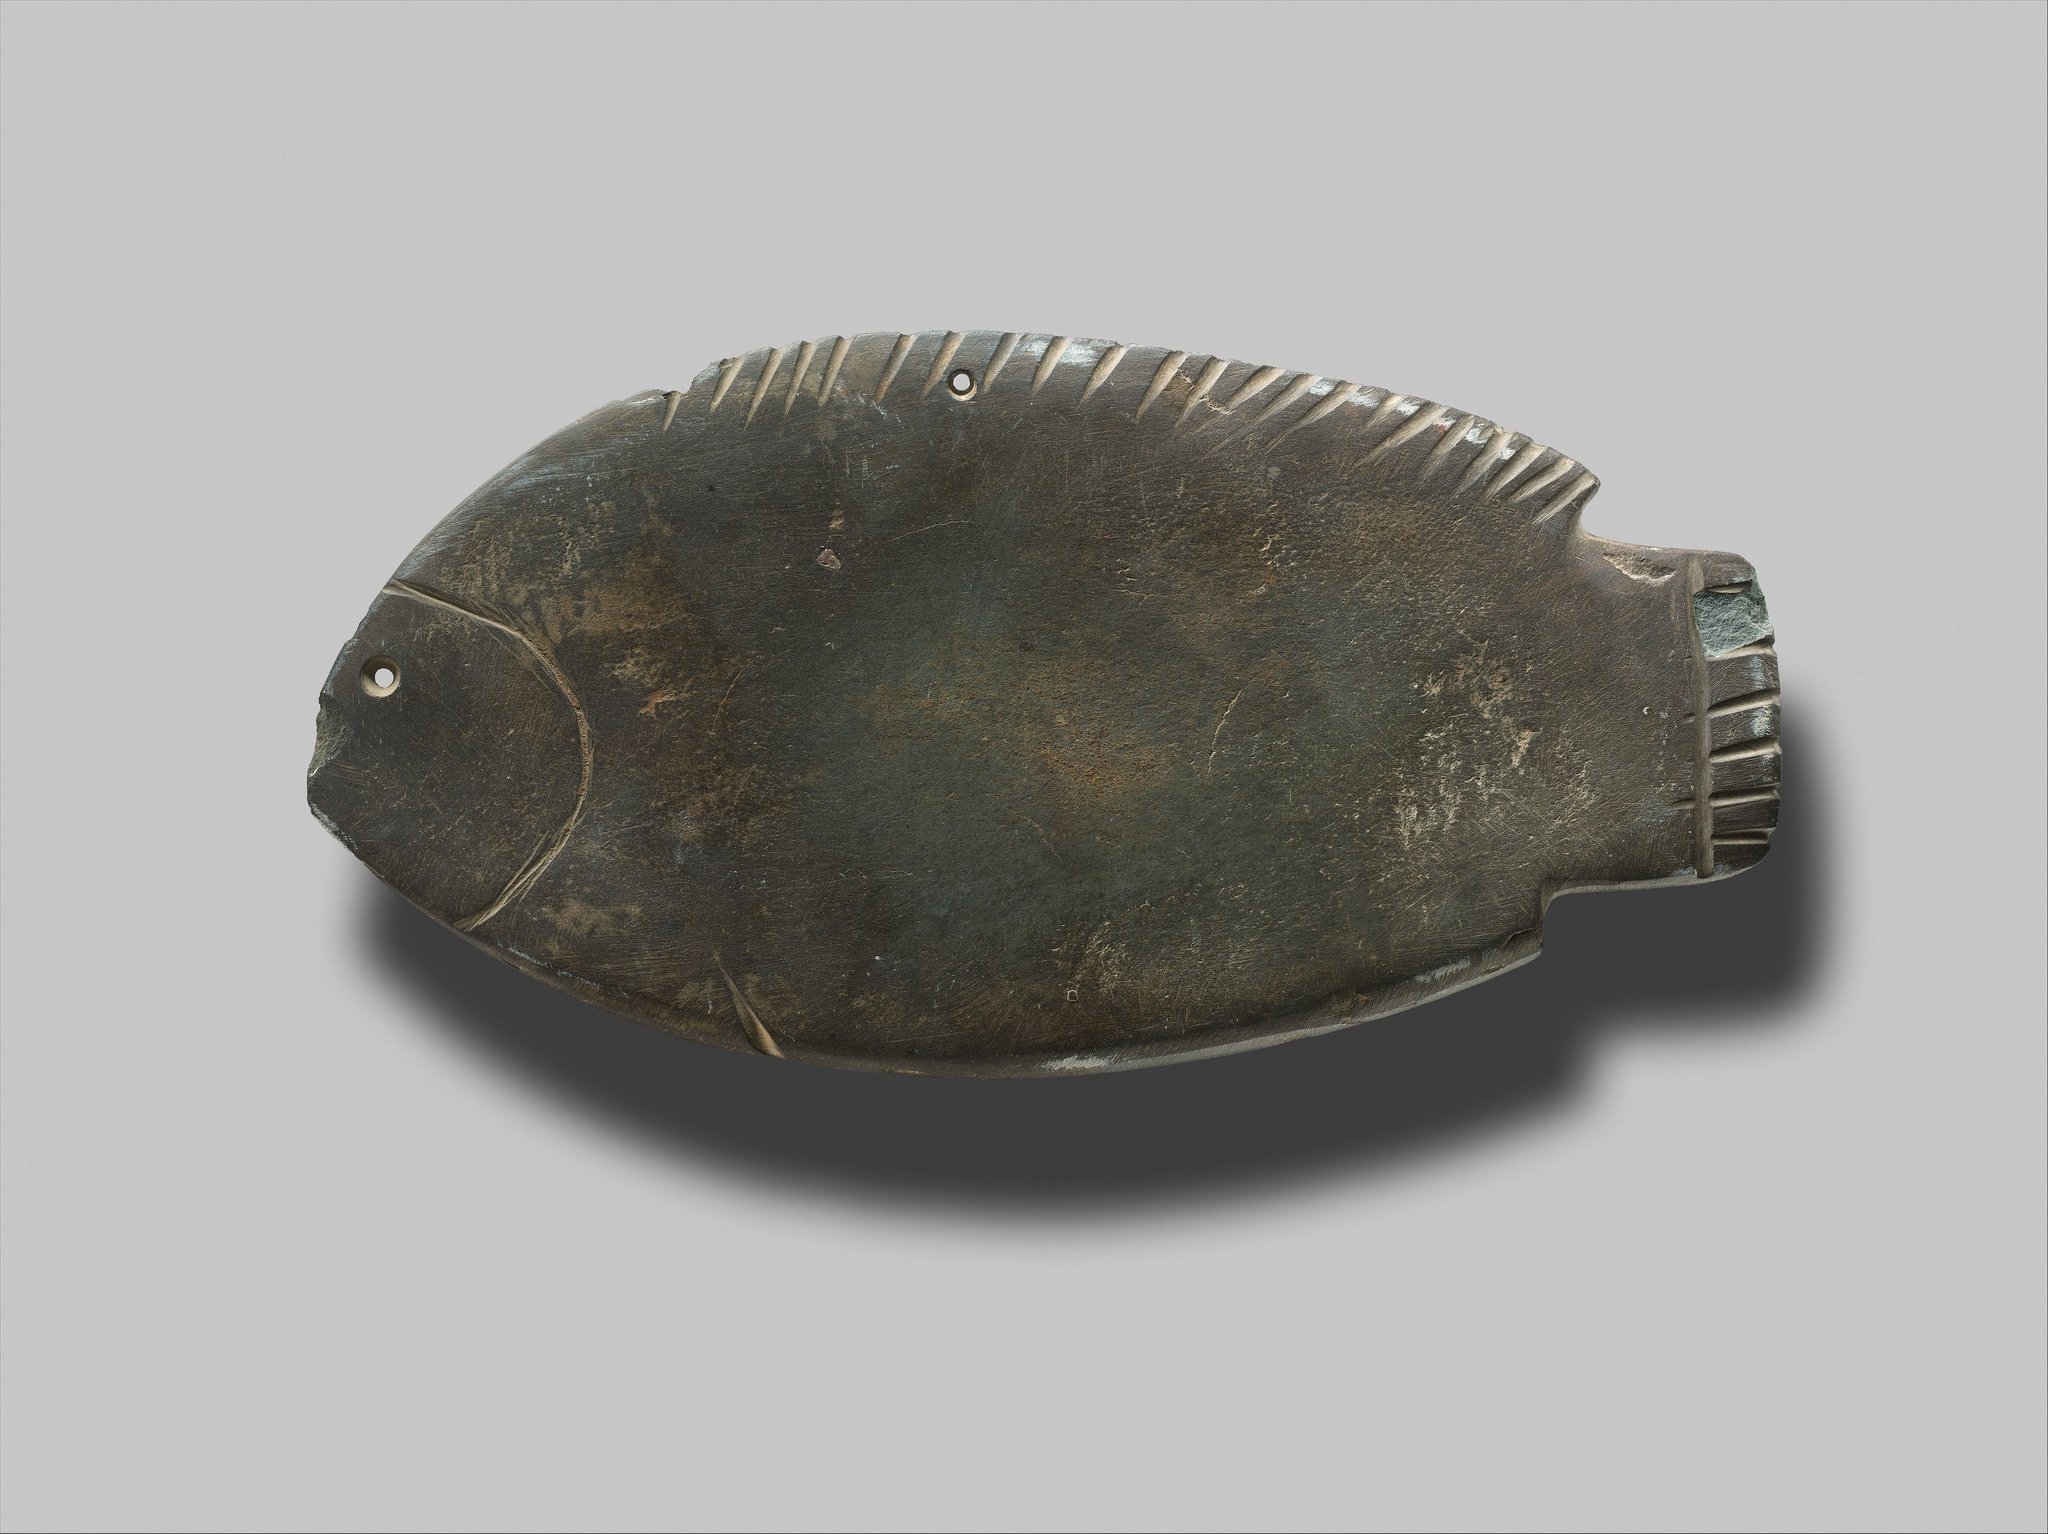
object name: palette, fish shaped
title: Fish-shaped palette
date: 3300-3100 BCE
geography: egypt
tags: fish